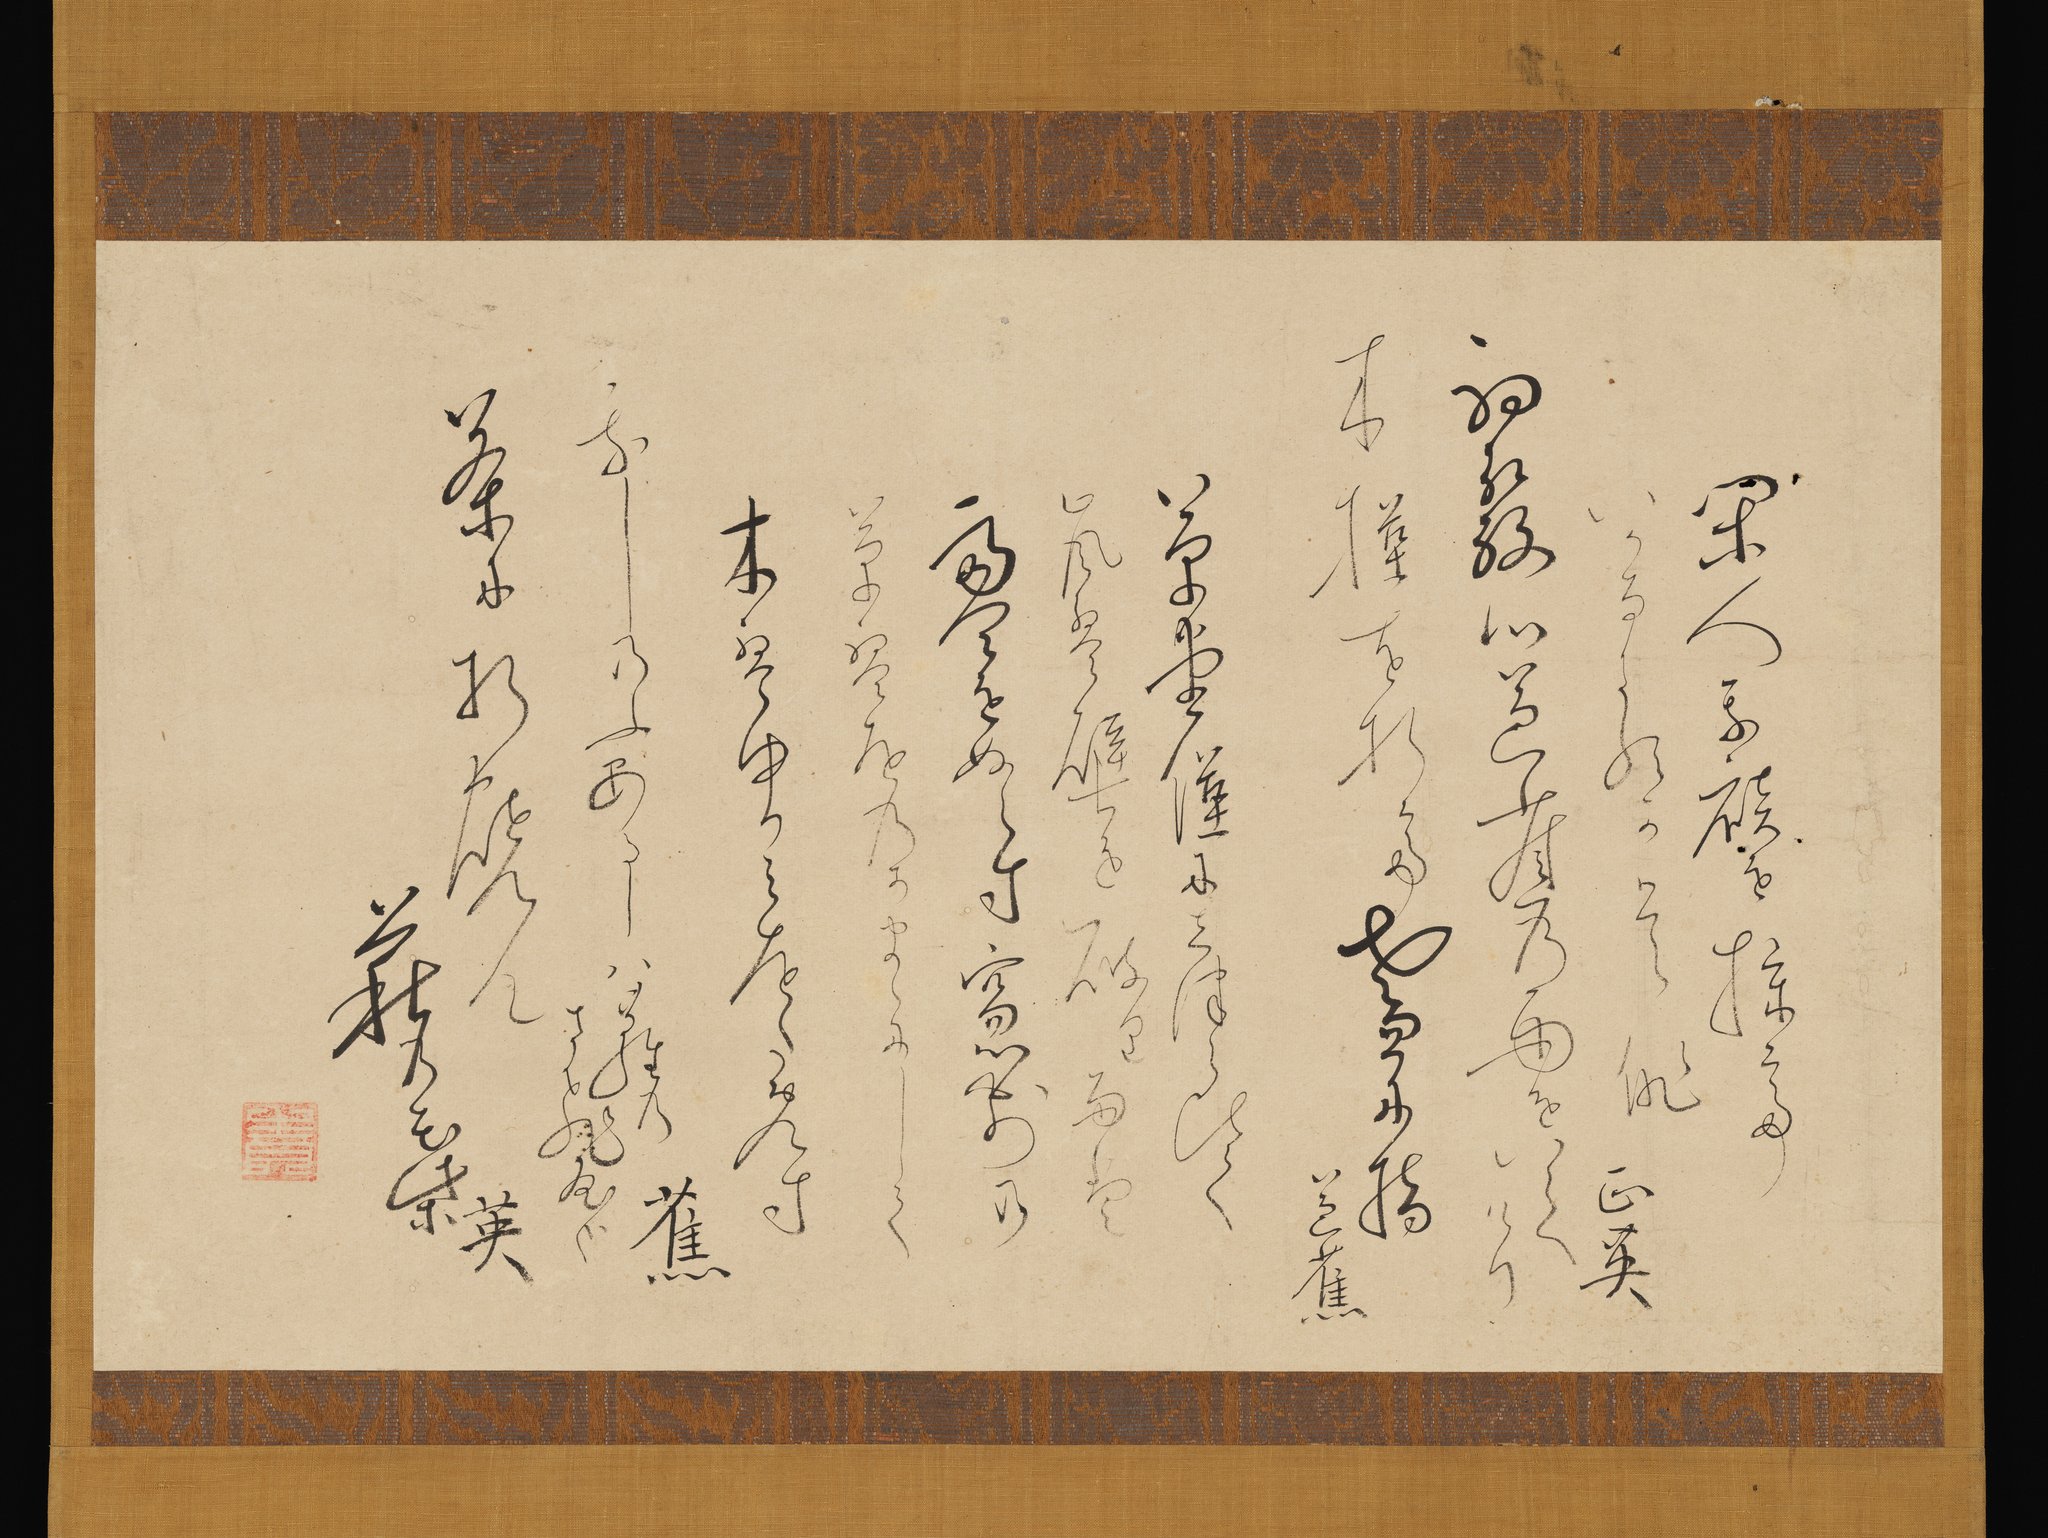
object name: hanging scroll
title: Record of a haiku exchange on kaishi writing paper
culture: japanese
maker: matsuo bashō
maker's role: artist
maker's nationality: japanese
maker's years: 1644-1694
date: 1651-1700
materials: ink, paper